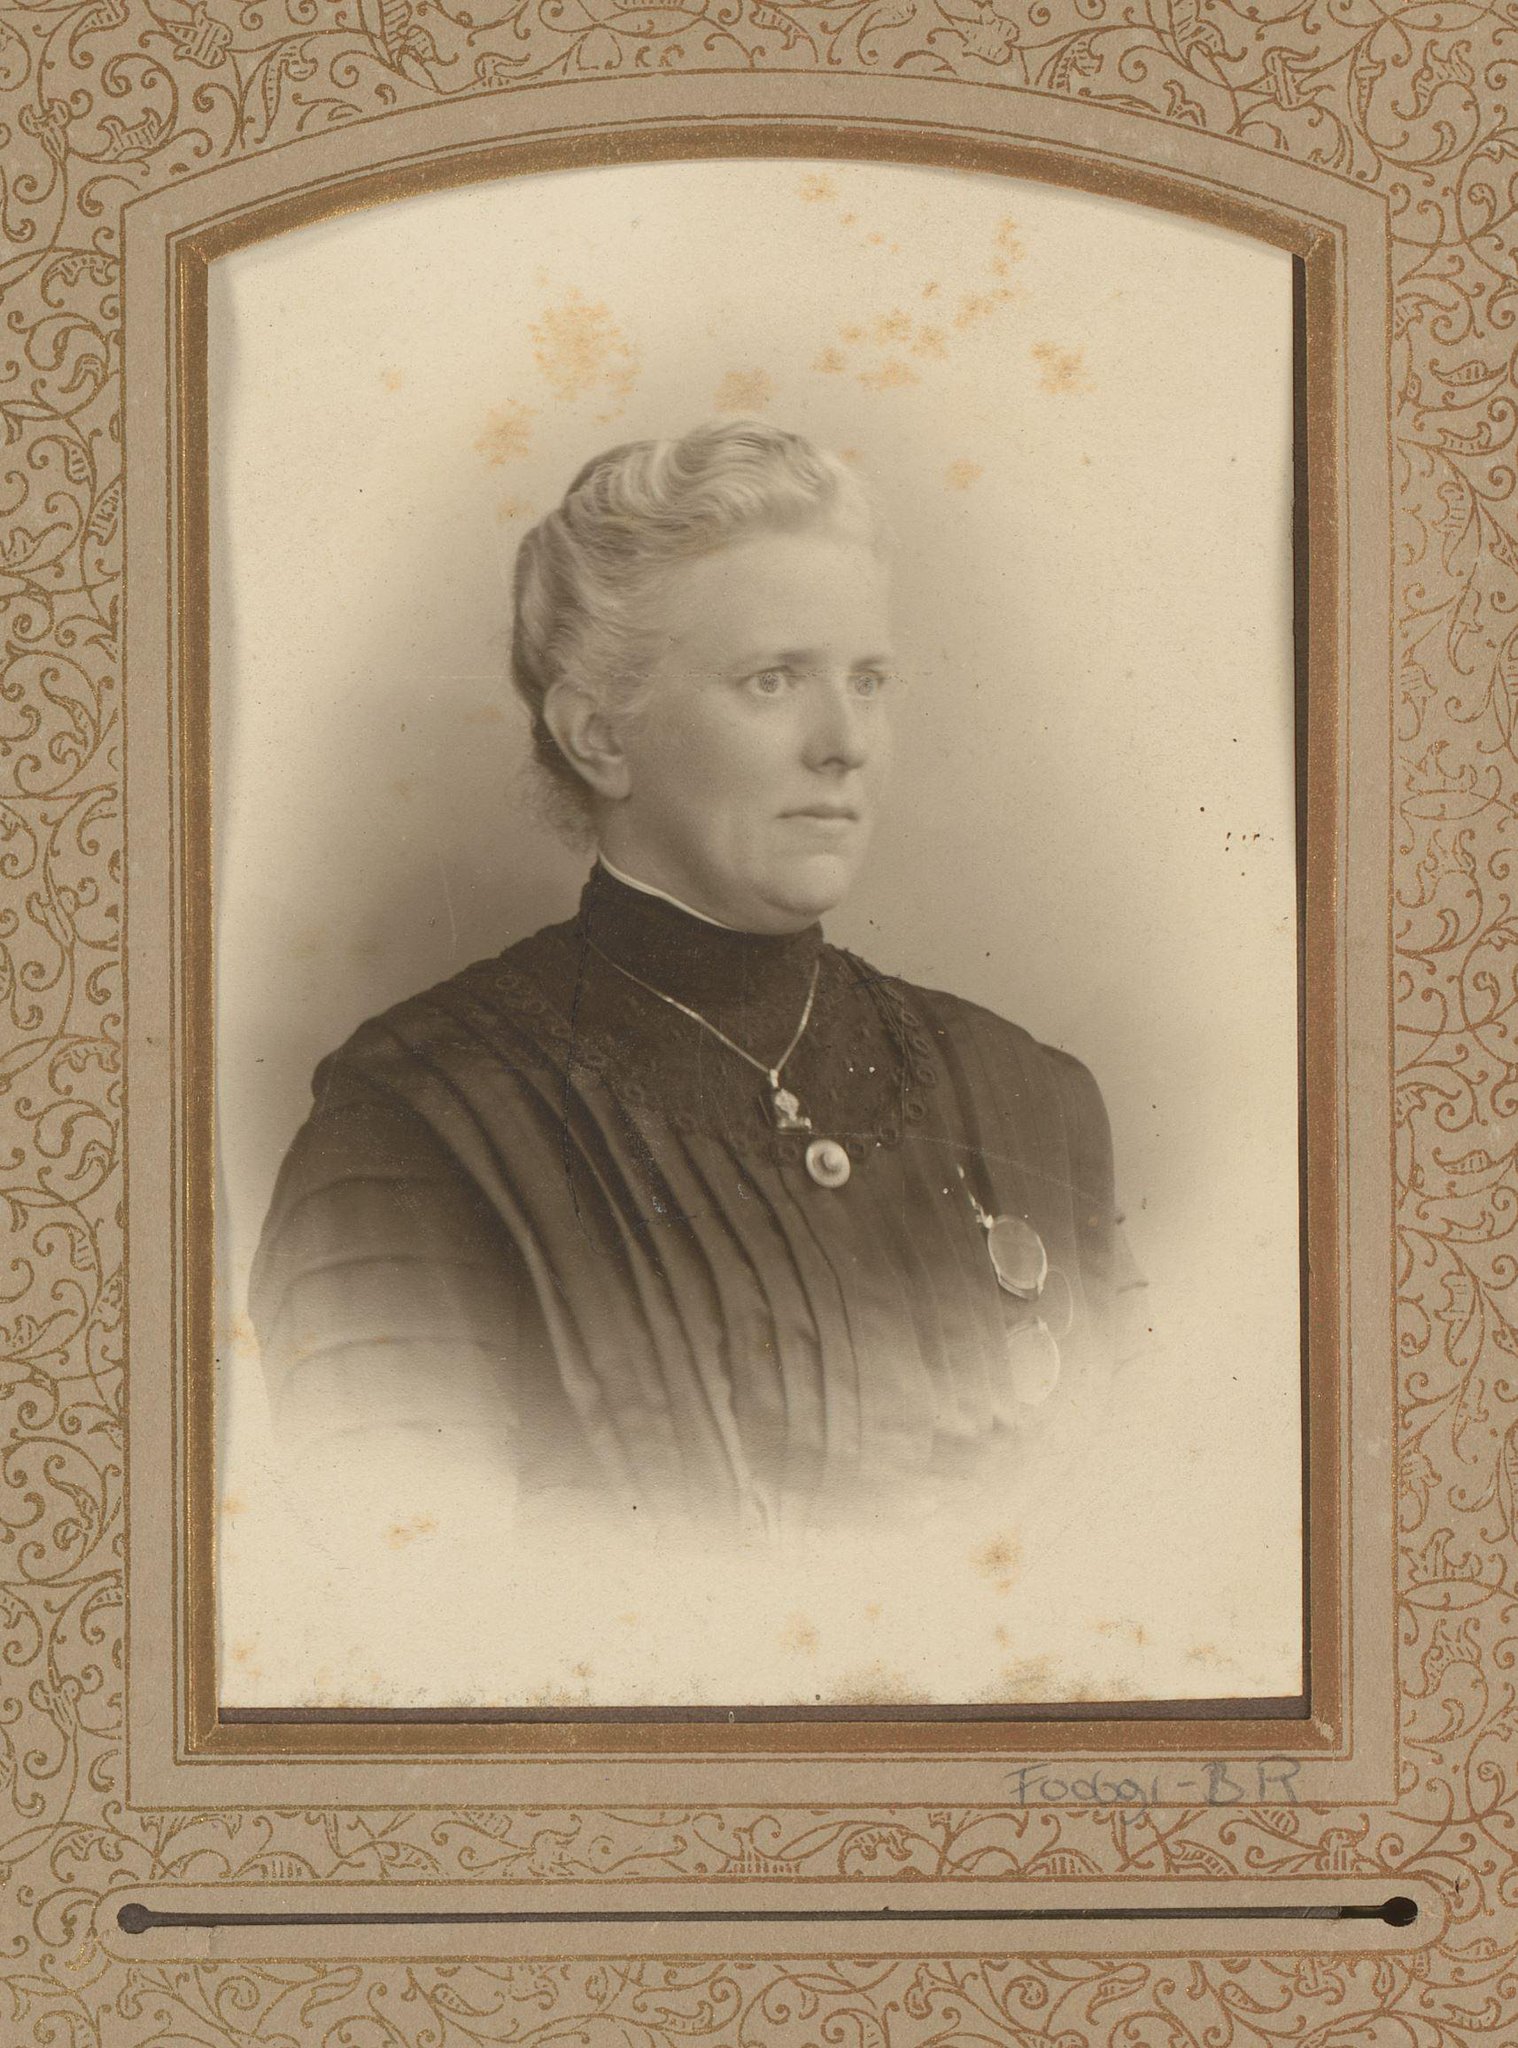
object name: cabinet photograph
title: Portret van een vrouw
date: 1913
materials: cardboard, photographic support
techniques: daylight paper print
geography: the hague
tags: historical persons - bb - woman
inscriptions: inscription: ‘A.M.A. Susan & Co./ Den Haag, Regentesselaan 196’